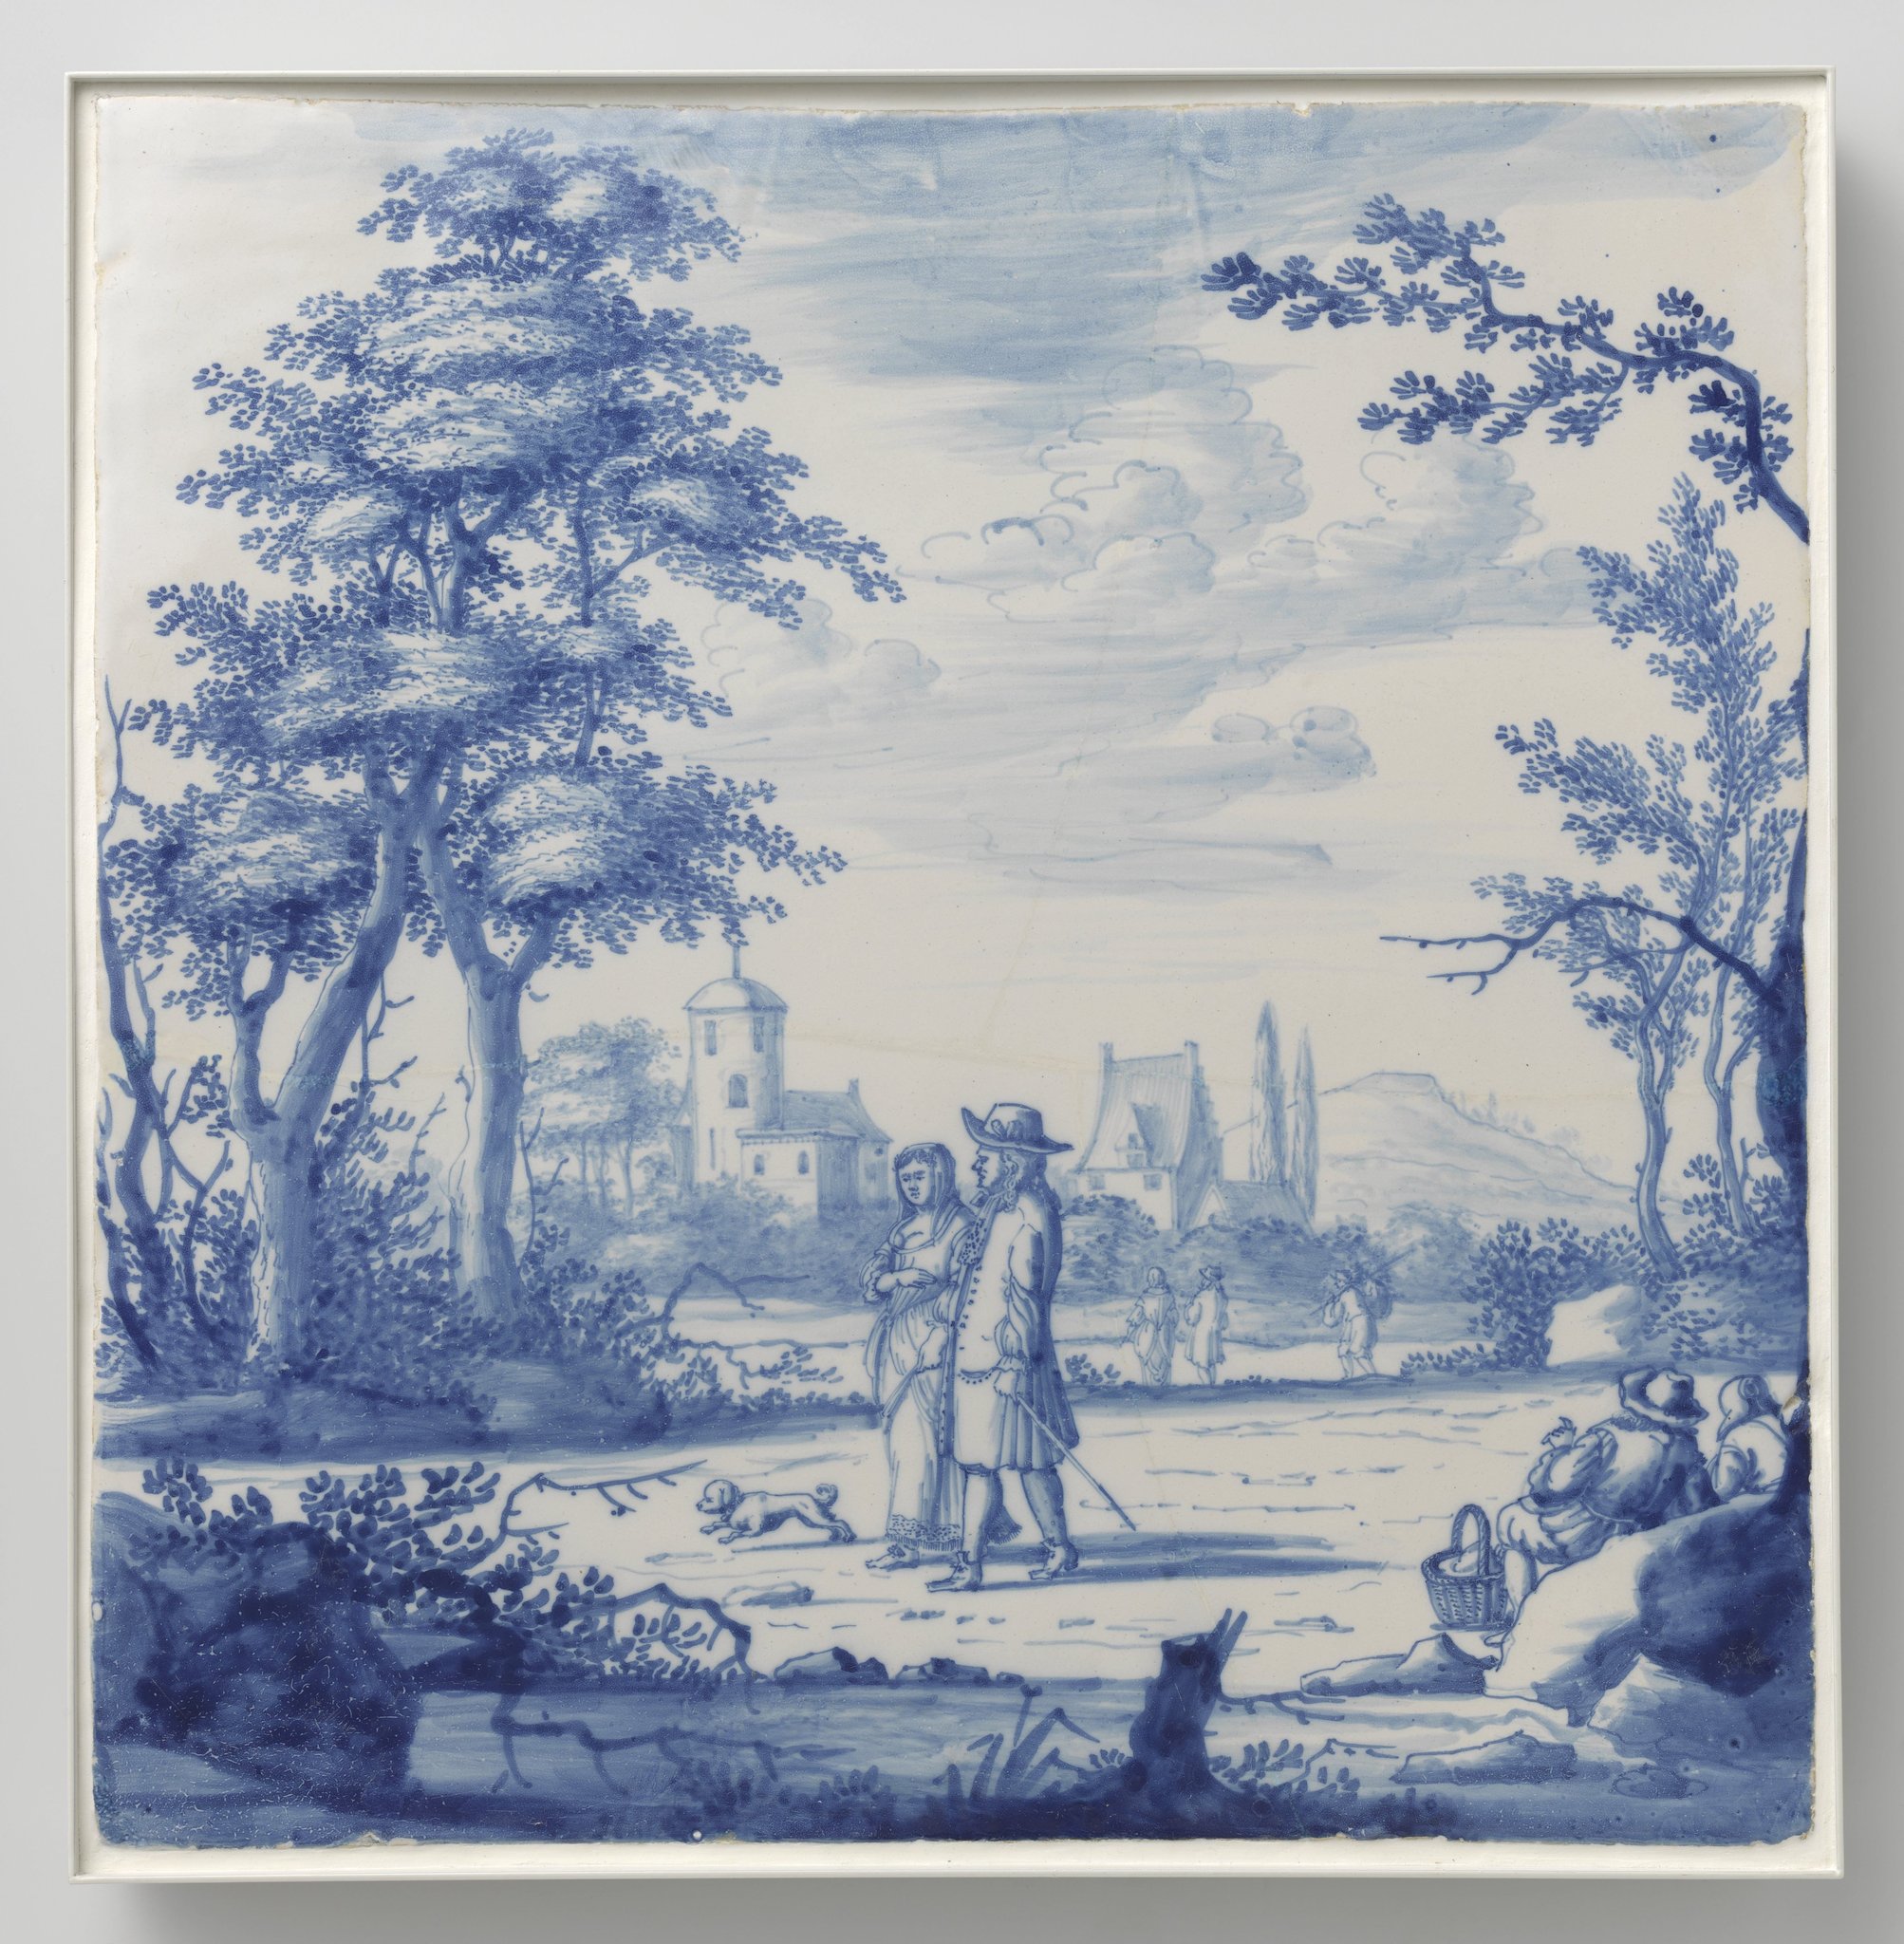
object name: plate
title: Plaat beschilderd met landschap met figuren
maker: Anonymous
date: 1680-1720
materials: faience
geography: delft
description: Plaat van faience, beschilderd met landschap met figuren